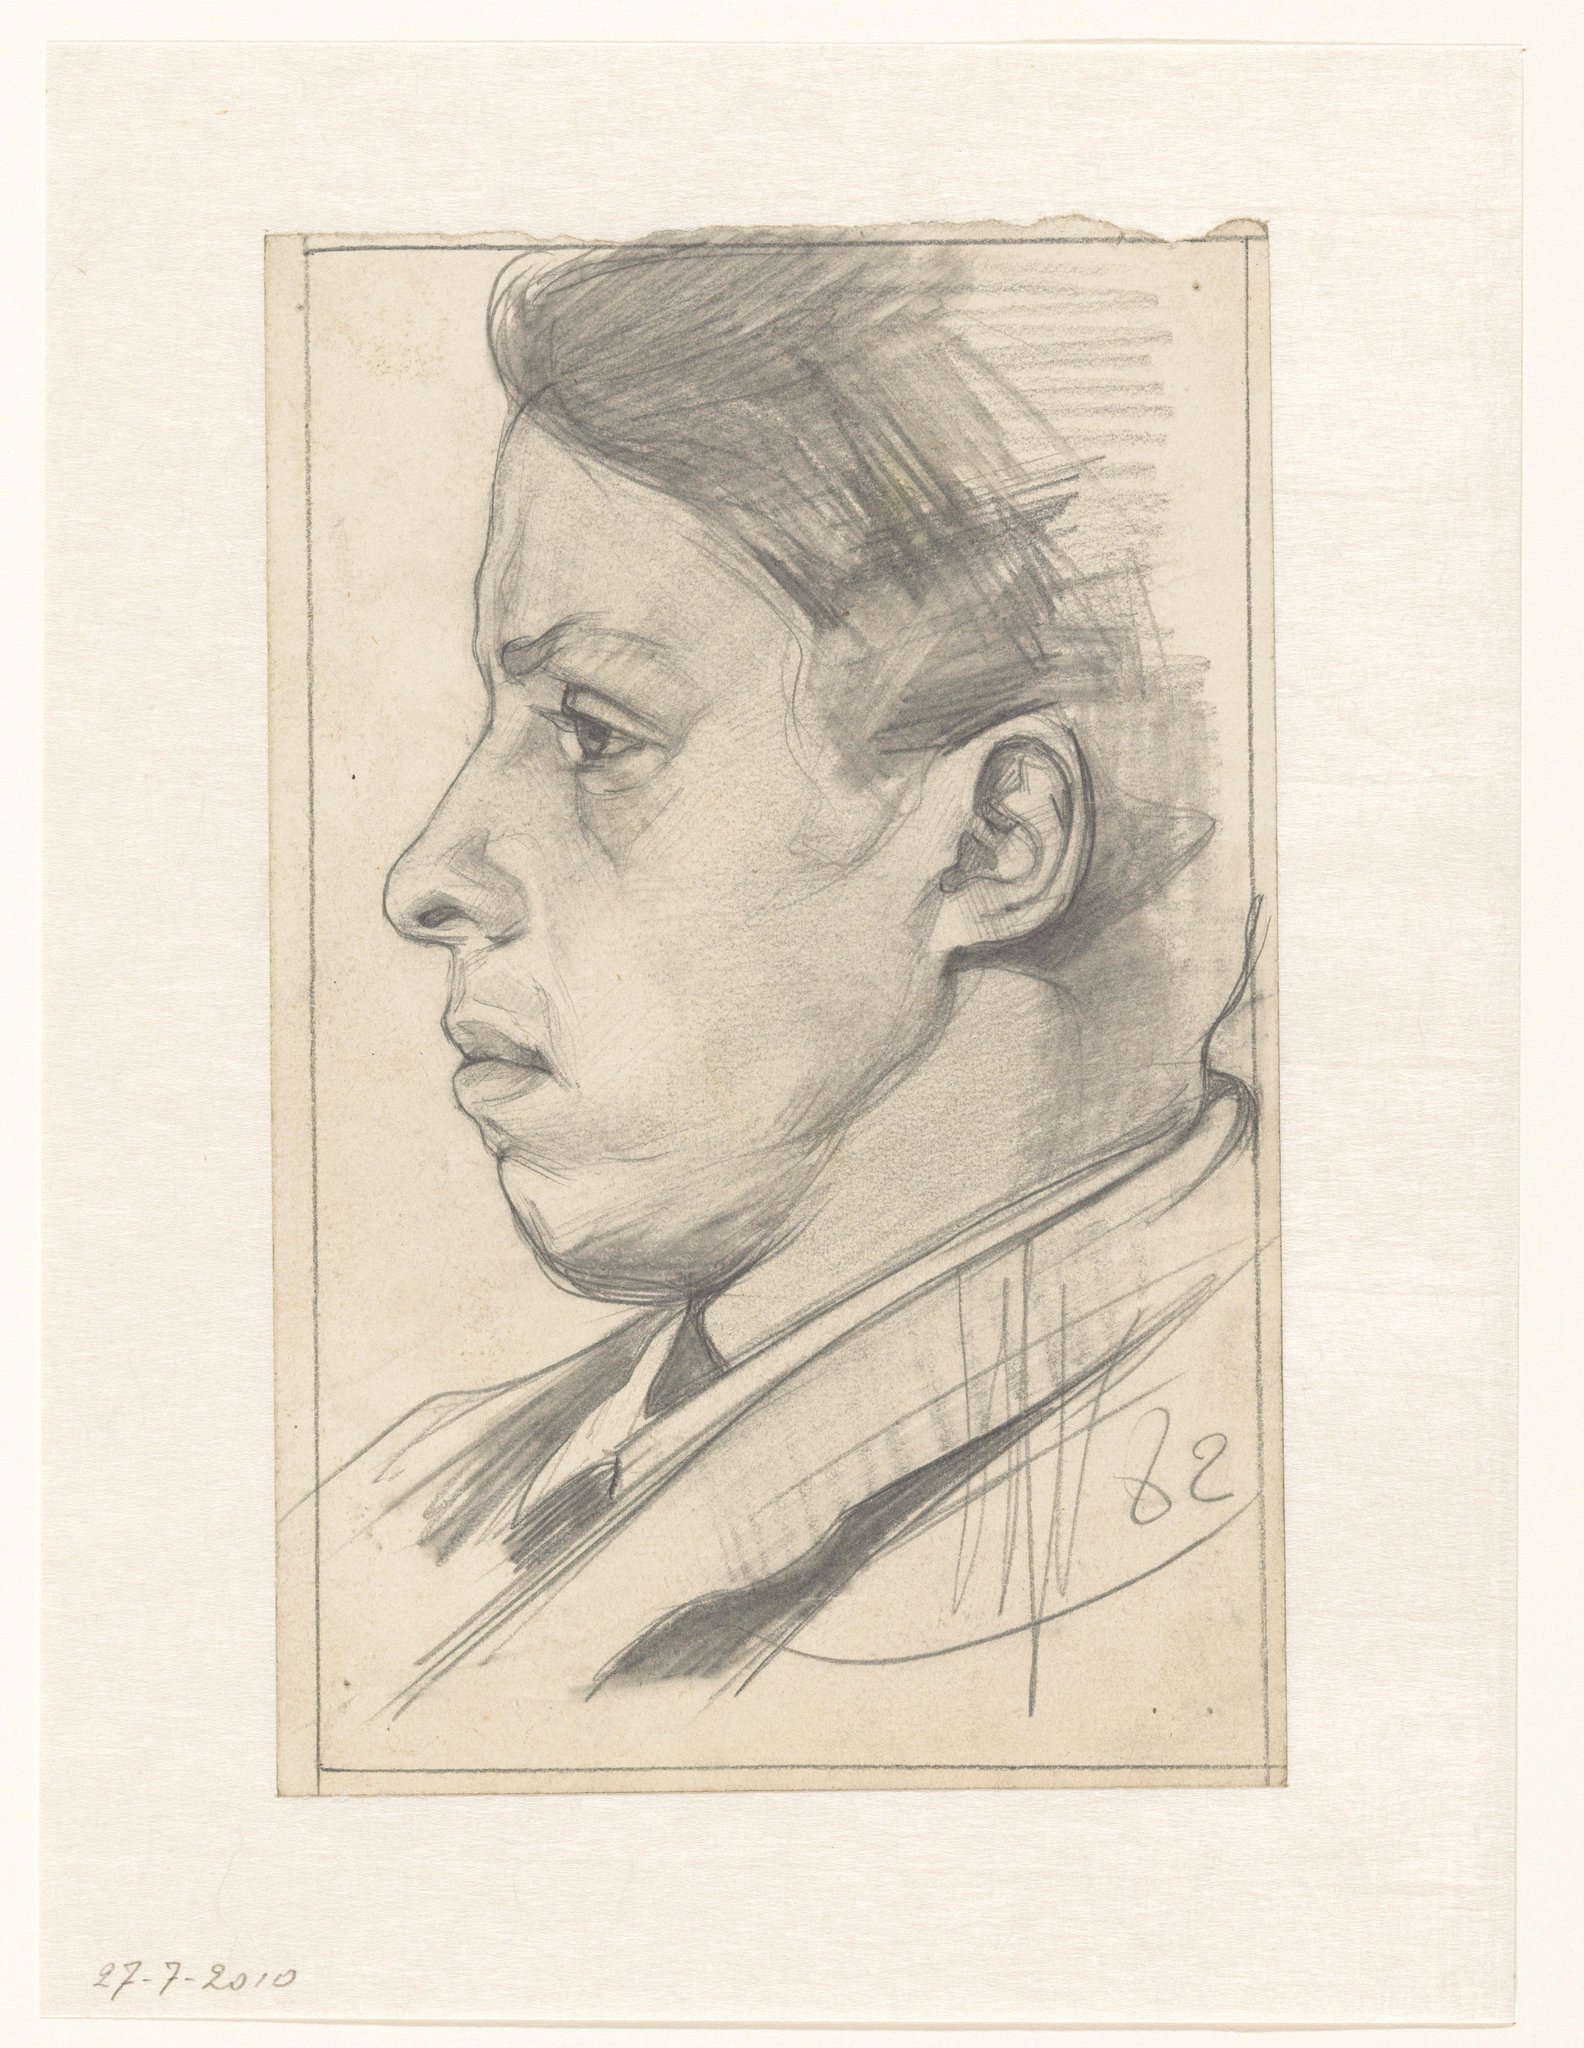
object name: drawing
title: Mansportret, in profiel naar links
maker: jan veth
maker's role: designer, draughtsman, painter, print maker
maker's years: 1864-1925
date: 1882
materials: paper, pencil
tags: anonymous historical person portrayed alone